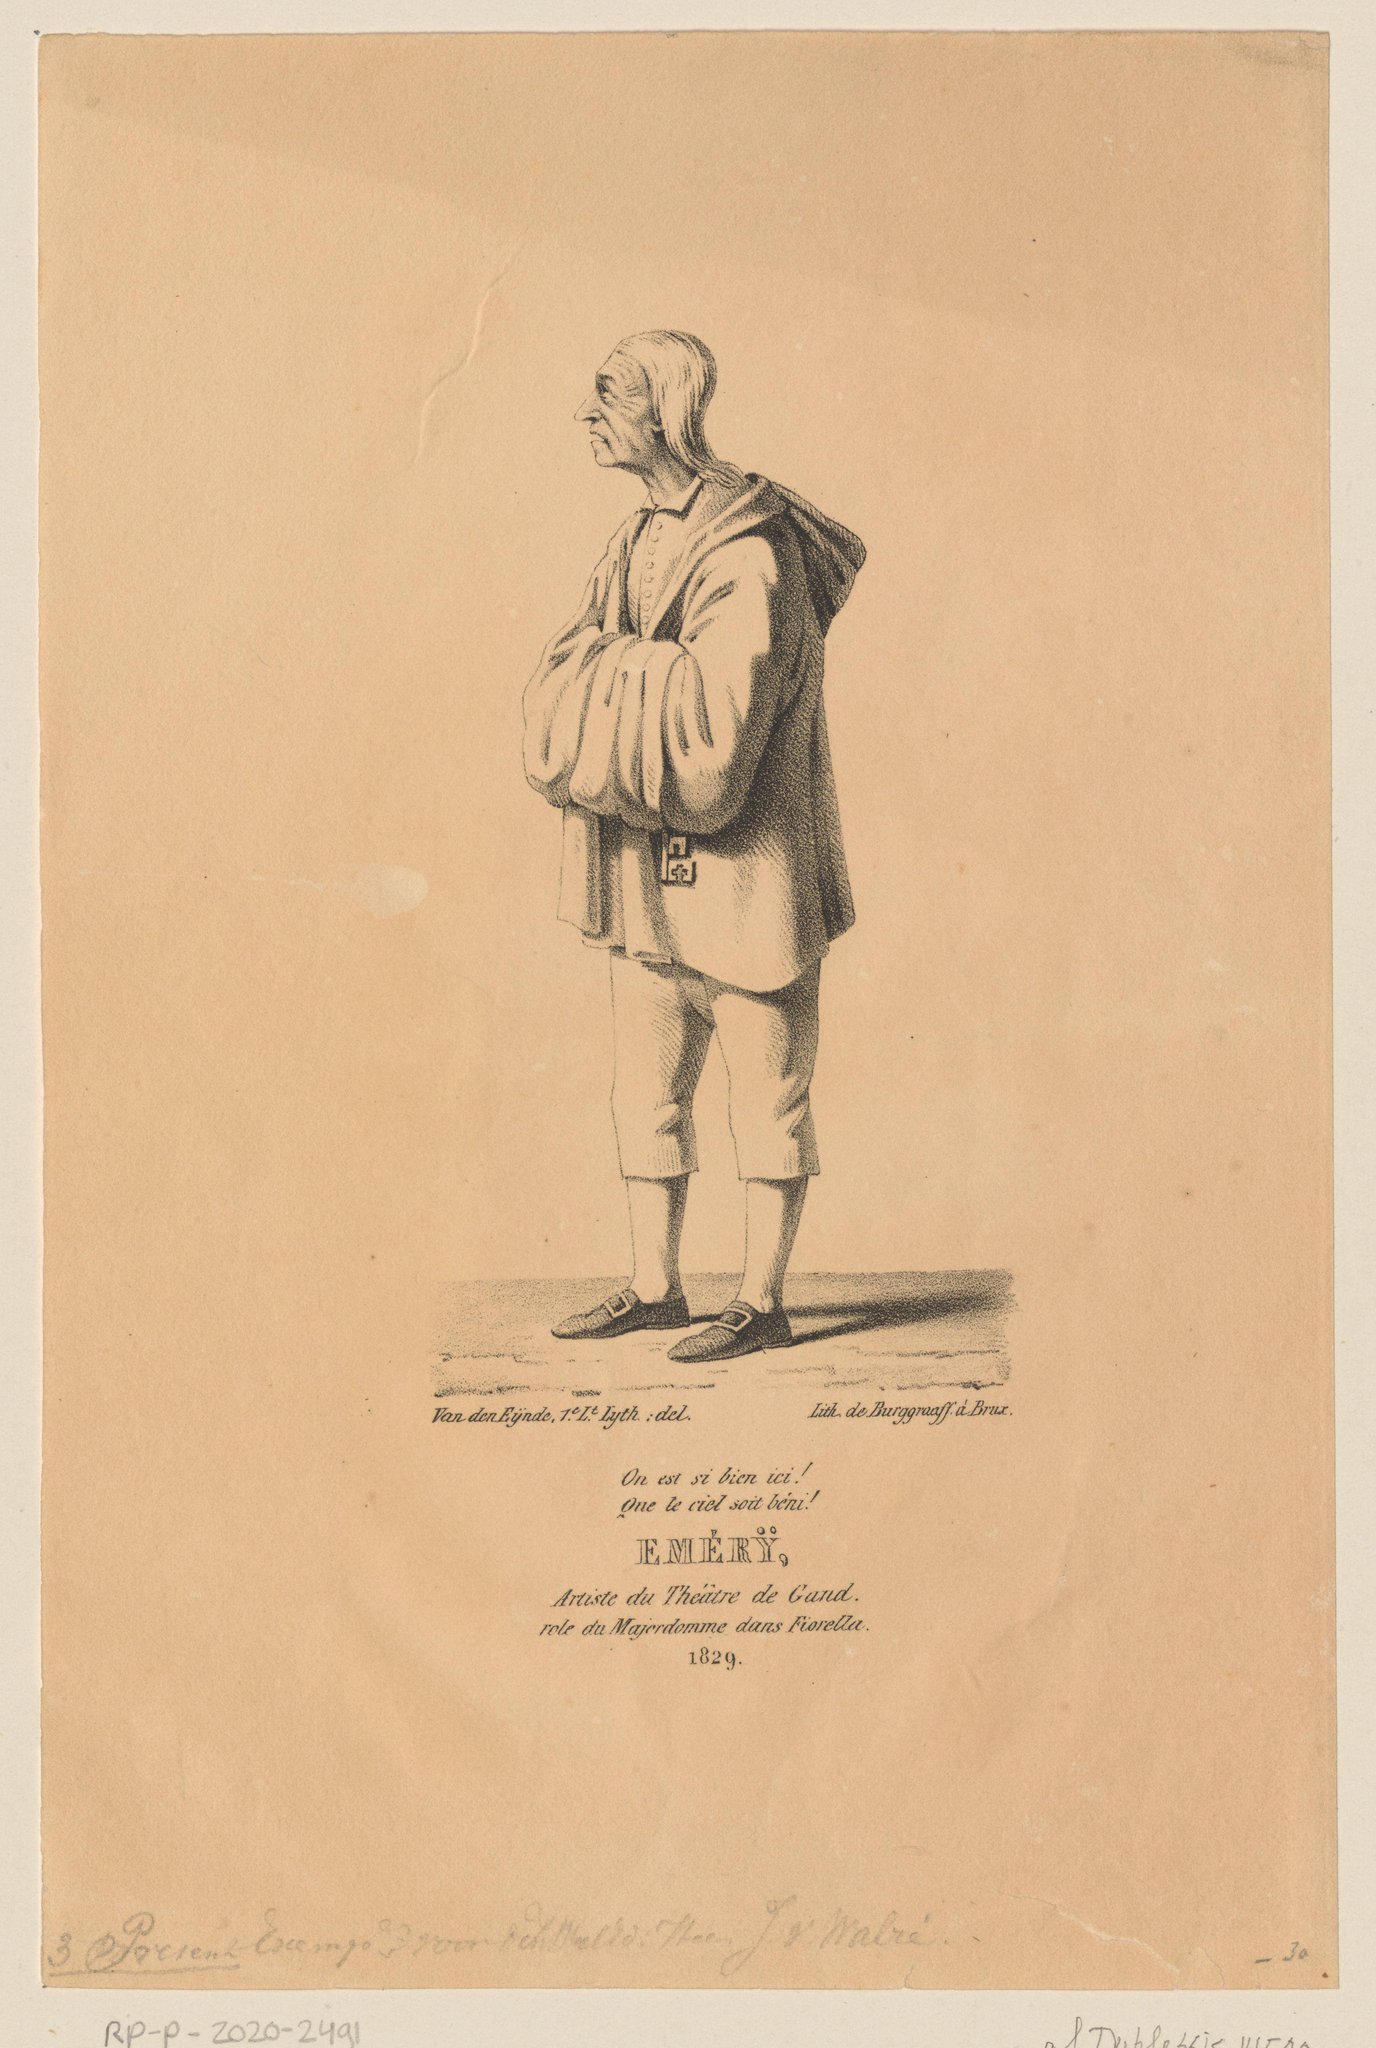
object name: print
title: Portret van acteur Emérij in de rol van Majordomo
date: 1829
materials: paper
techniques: lithograph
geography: brussels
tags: portrait of actor, actress (+ artist at work), historical persons (+ full length portrait)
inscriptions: date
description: Onder het portret zijn naam en een vierregelig onderschrift met daarin zijn rol: Majordomo in de opera Fiorella.